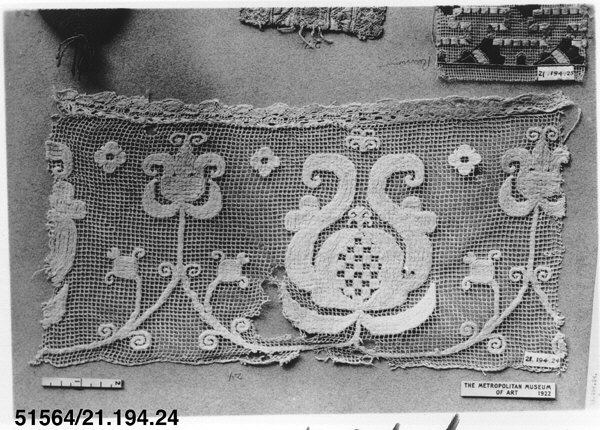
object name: strip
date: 1701-1800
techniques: embroidery